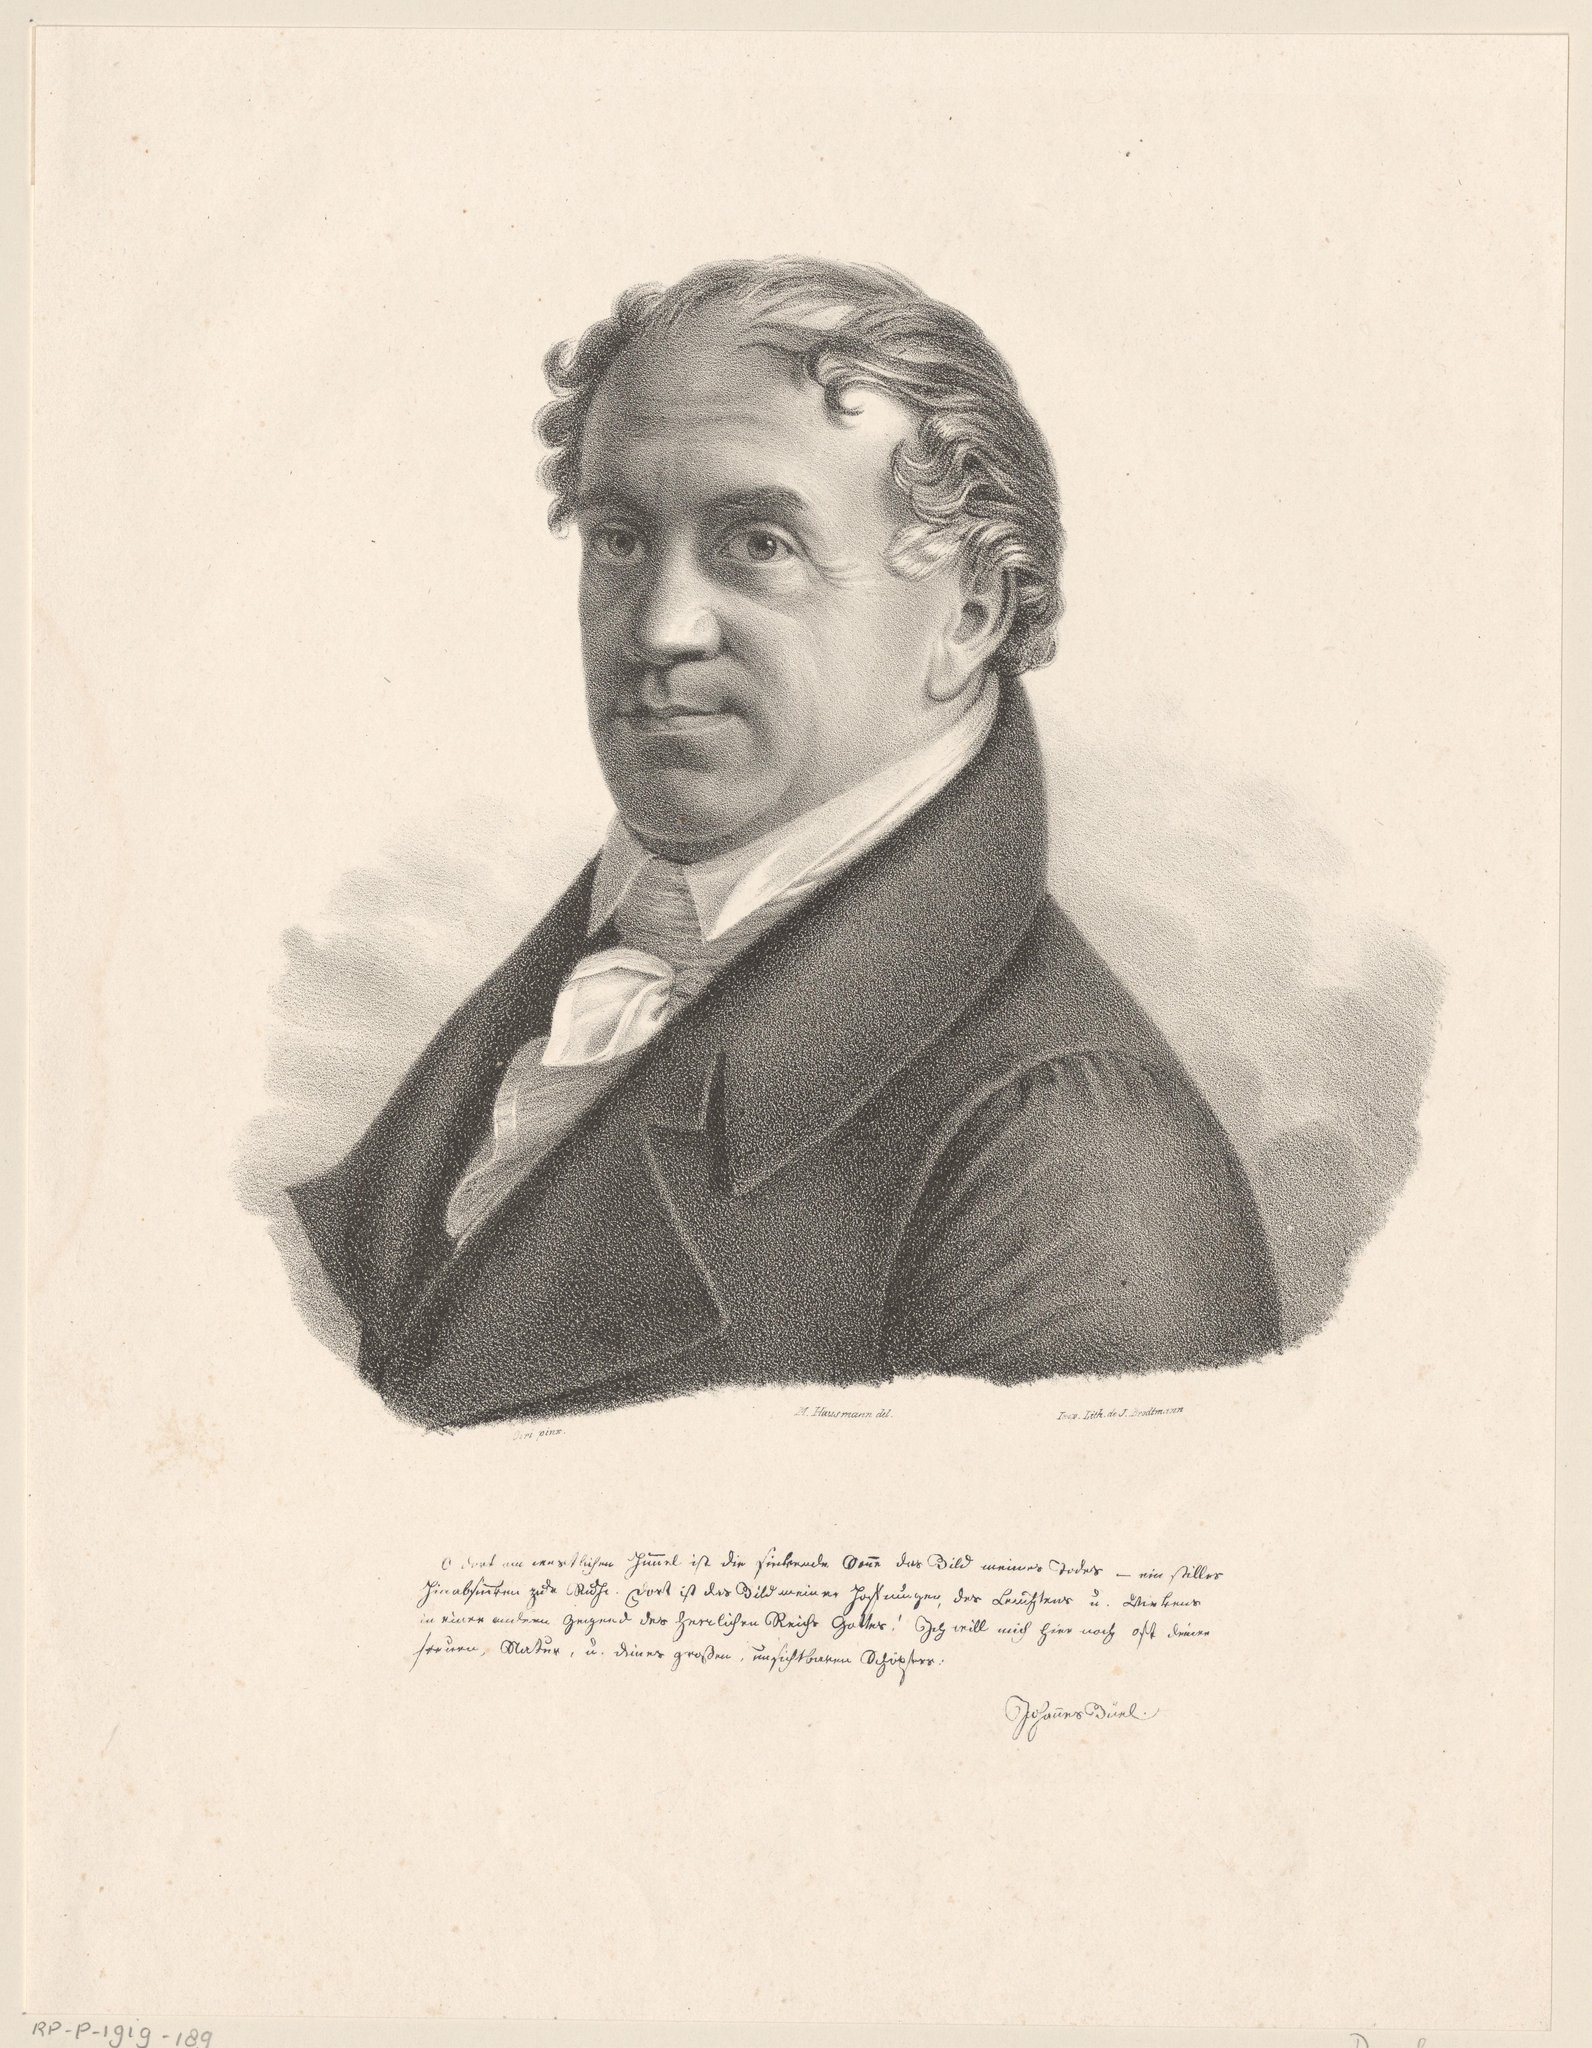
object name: print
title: Portret van Johannes Büel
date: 1797-1861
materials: paper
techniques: lithograph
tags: historical persons, scholastic education, tuition (+ portrait of teacher, professor)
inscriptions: collector's mark: Lugt 2228